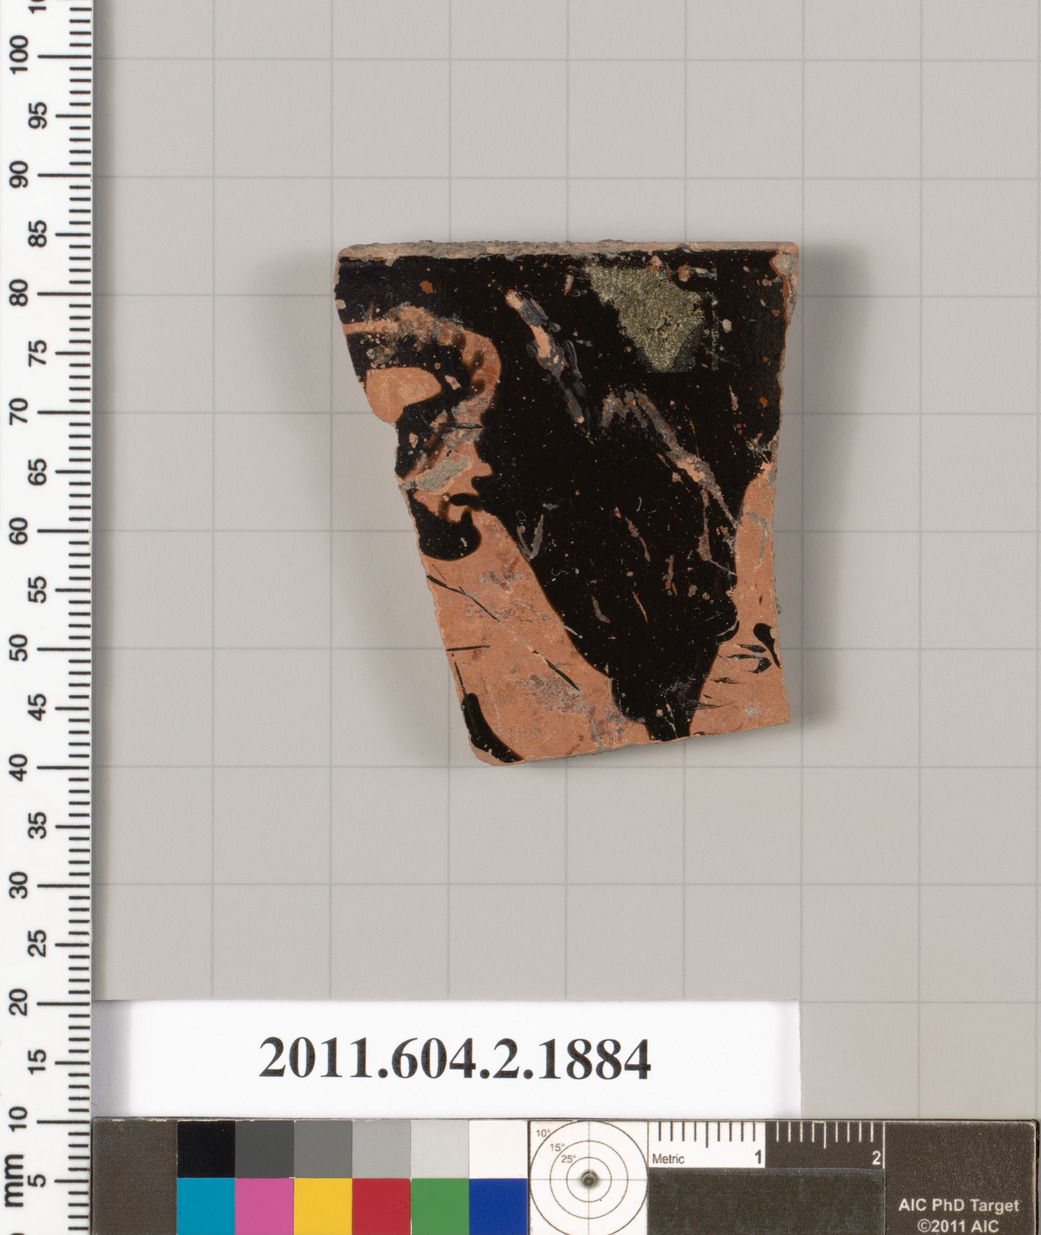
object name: skyphos fragment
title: Terracotta rim fragment of a skyphos (deep drinking cup)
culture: greek, attic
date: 425-401 BCE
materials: terracotta